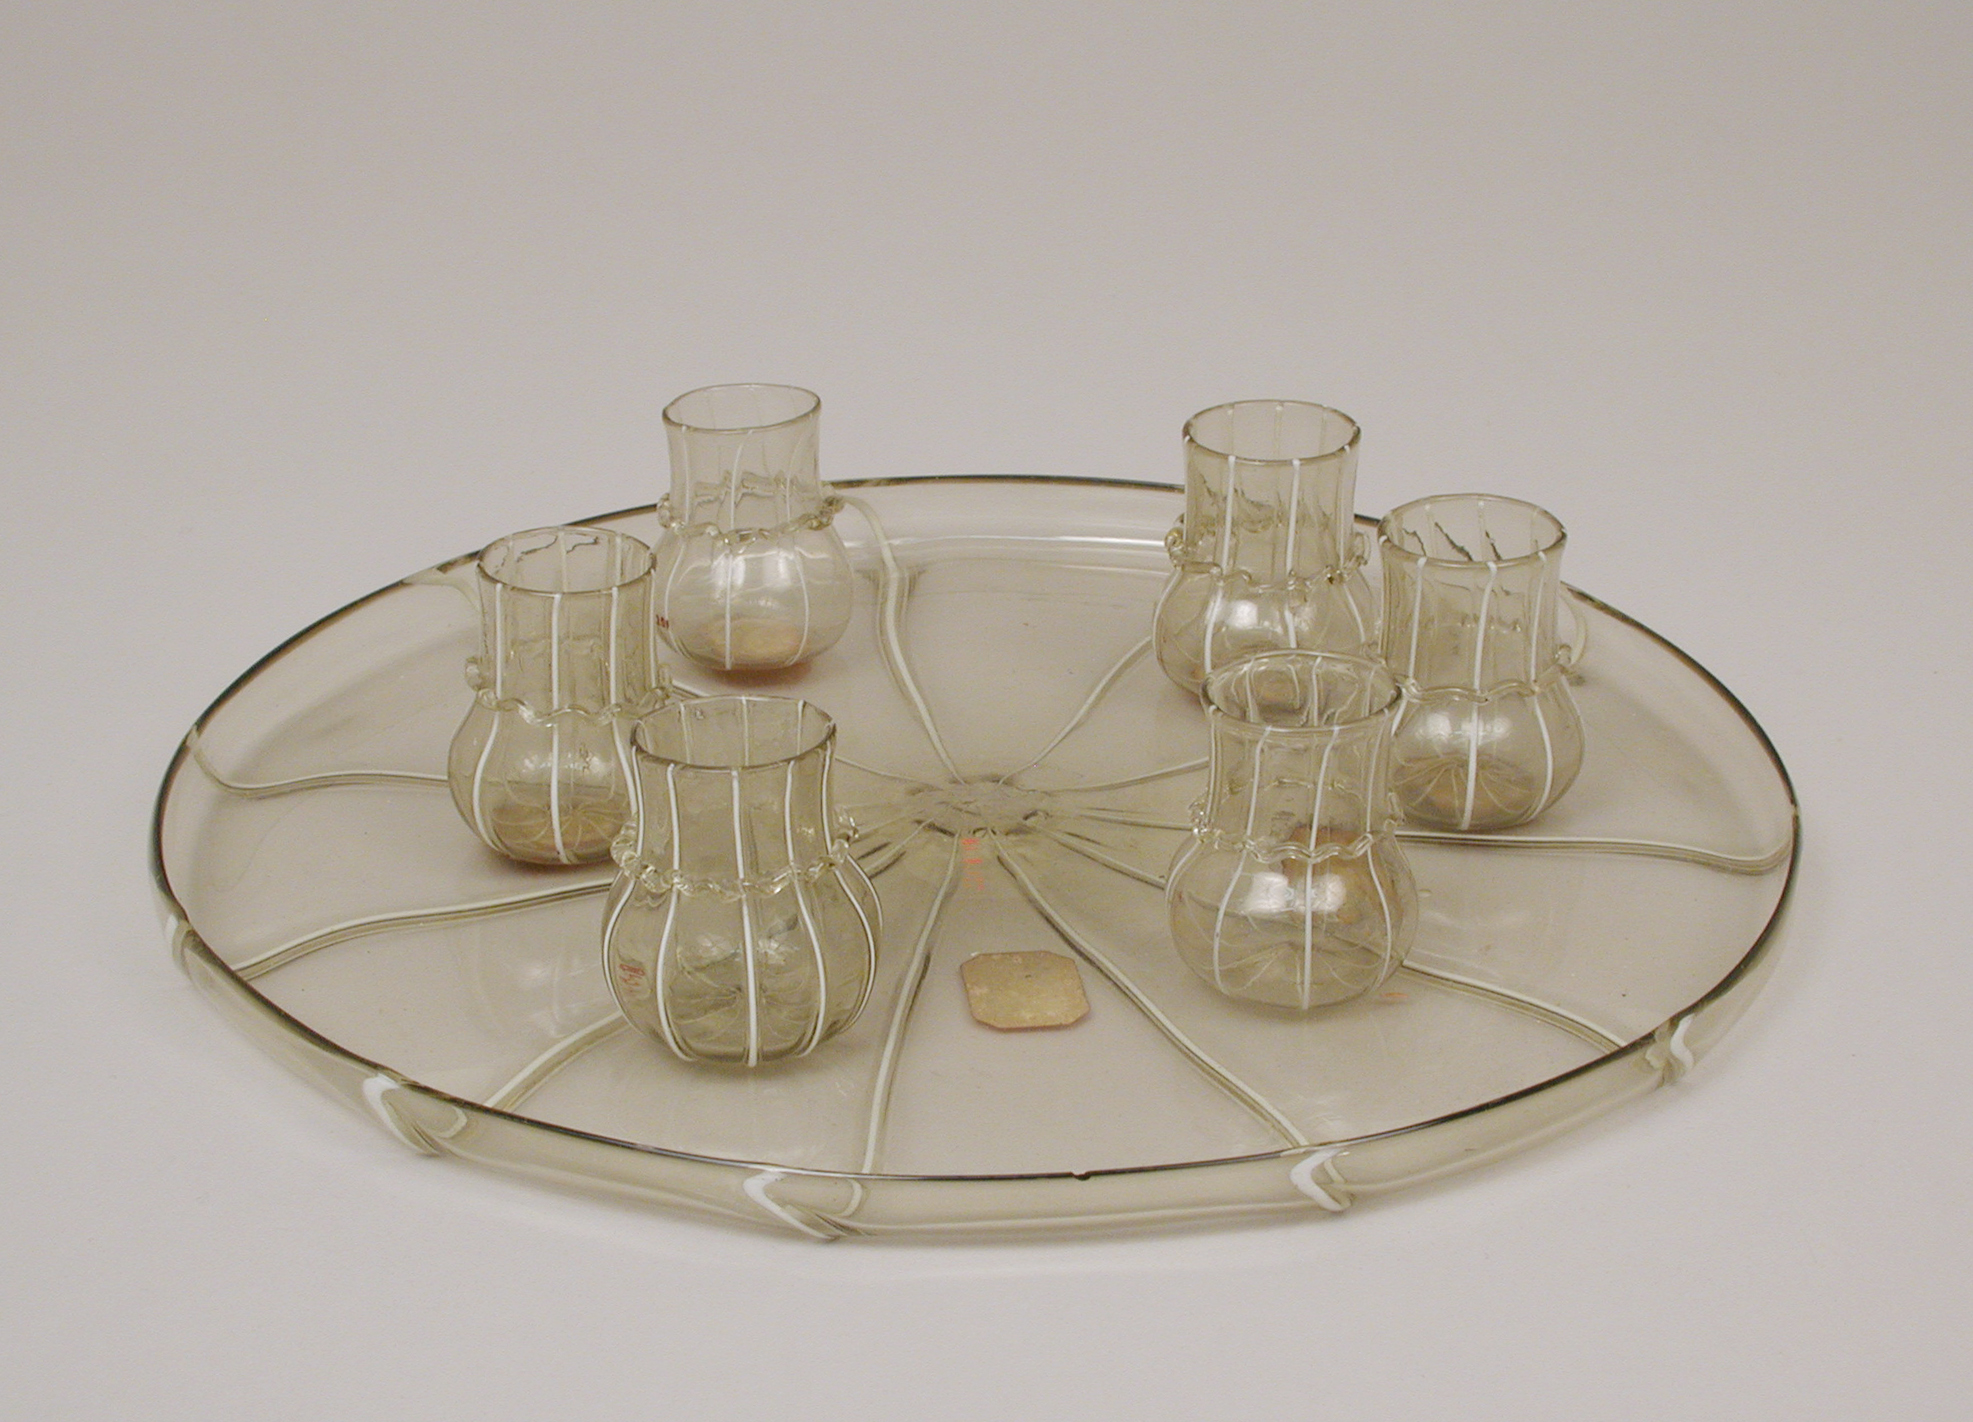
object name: schnapps glass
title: Schnapps glass (one of six)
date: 1801-1900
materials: glass